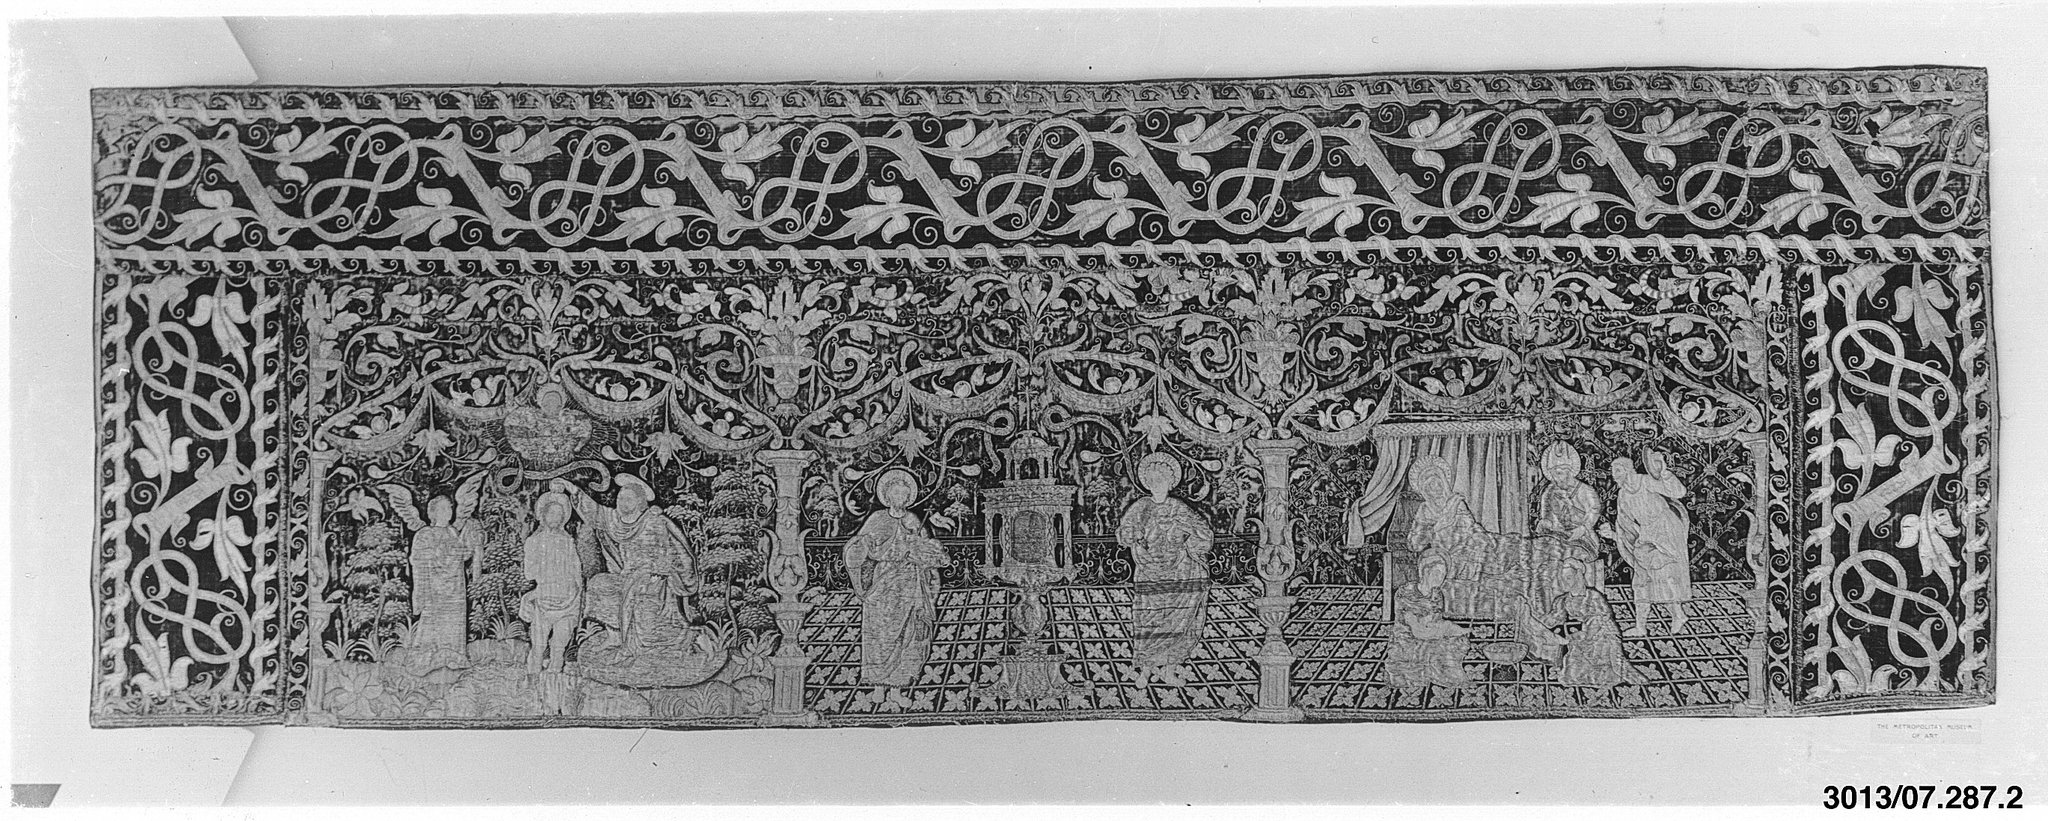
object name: altar frontal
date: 1501-1600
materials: metal thread, silk, velvet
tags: christ,saint john the baptist